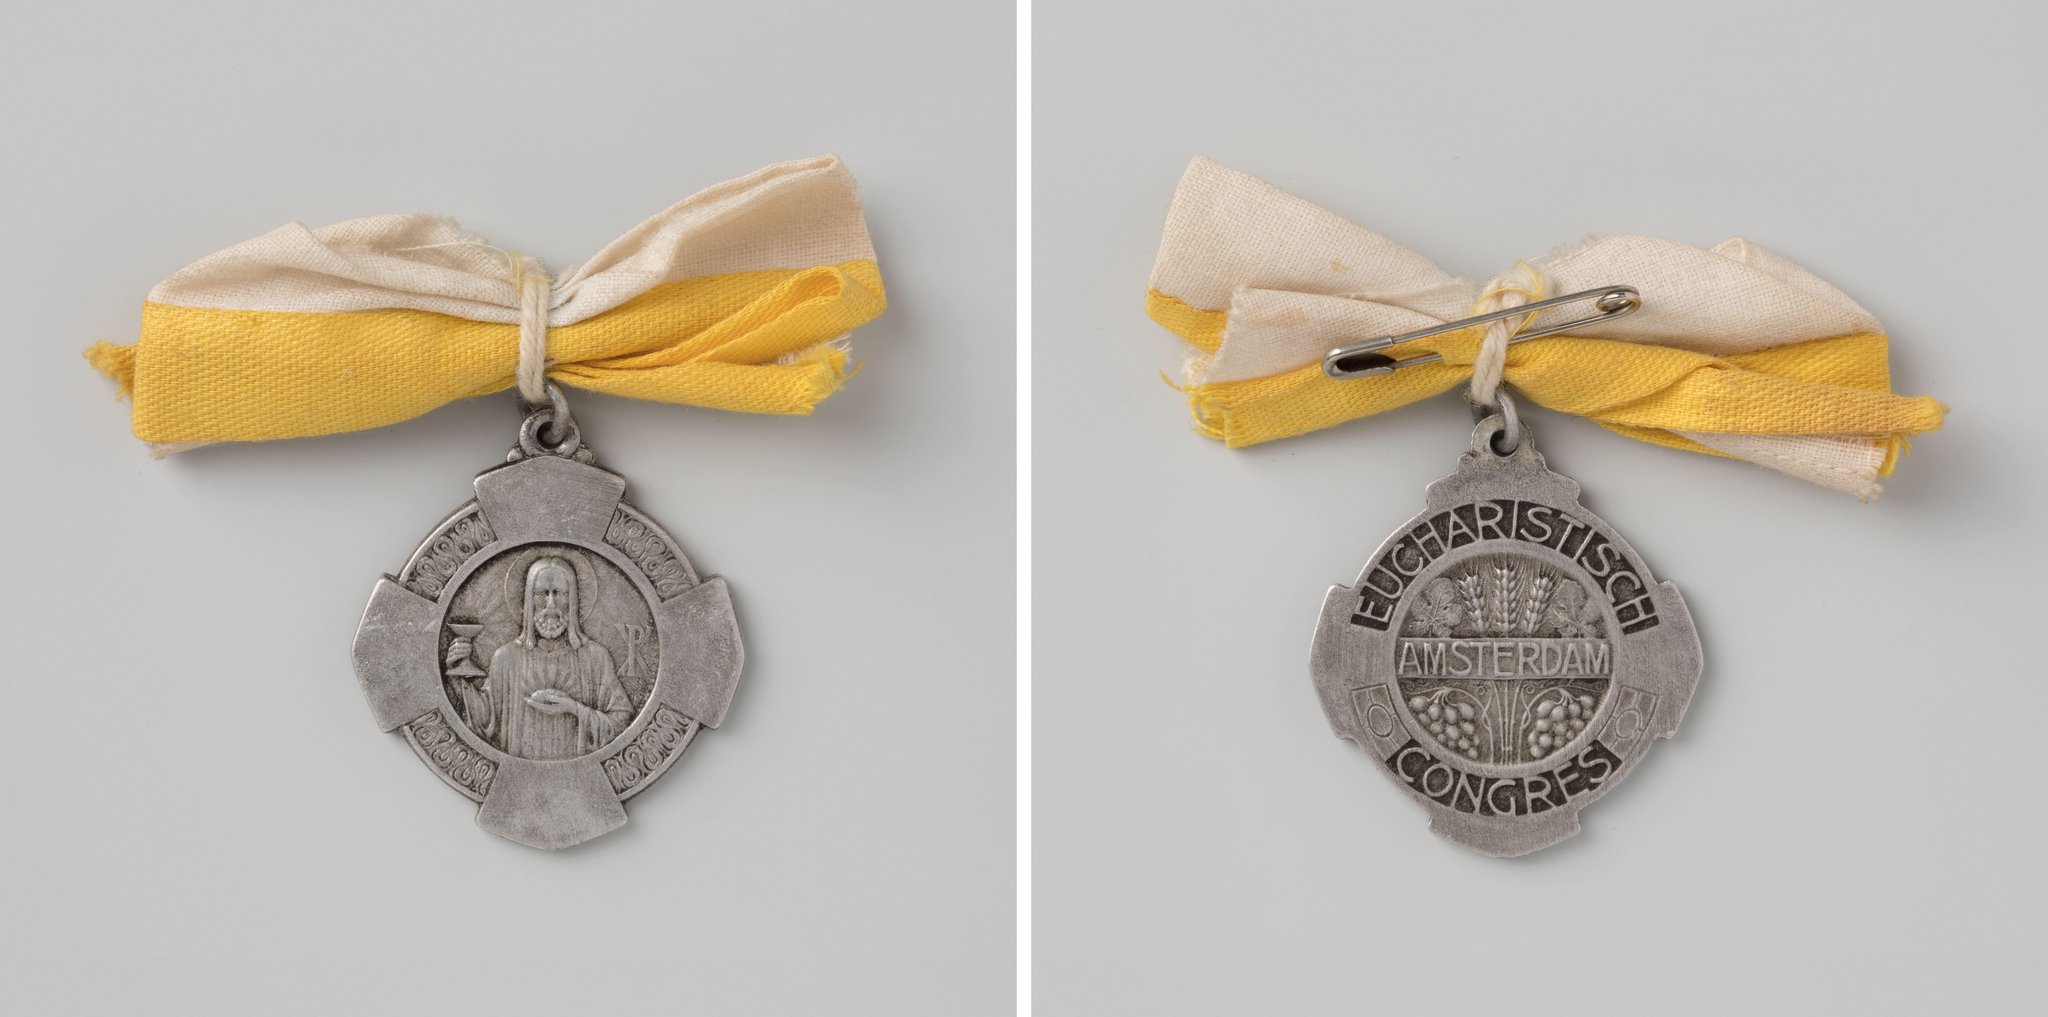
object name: history medal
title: Draagpenning van het Eucharistisch Congres te Amsterdam 1922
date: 1922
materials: aluminum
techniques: striking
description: Aluminium draagteken met oog en draagring aan een geel-witte strik, de voorzijde als een kruis met in het midden Christus met stralende kelk en hostie, met omschrift op een verdiept veld tussen de benen, op de keerzijde de plaatsnaam op drie korenaren en wijnloof, met omschrift op een verdiept veld.